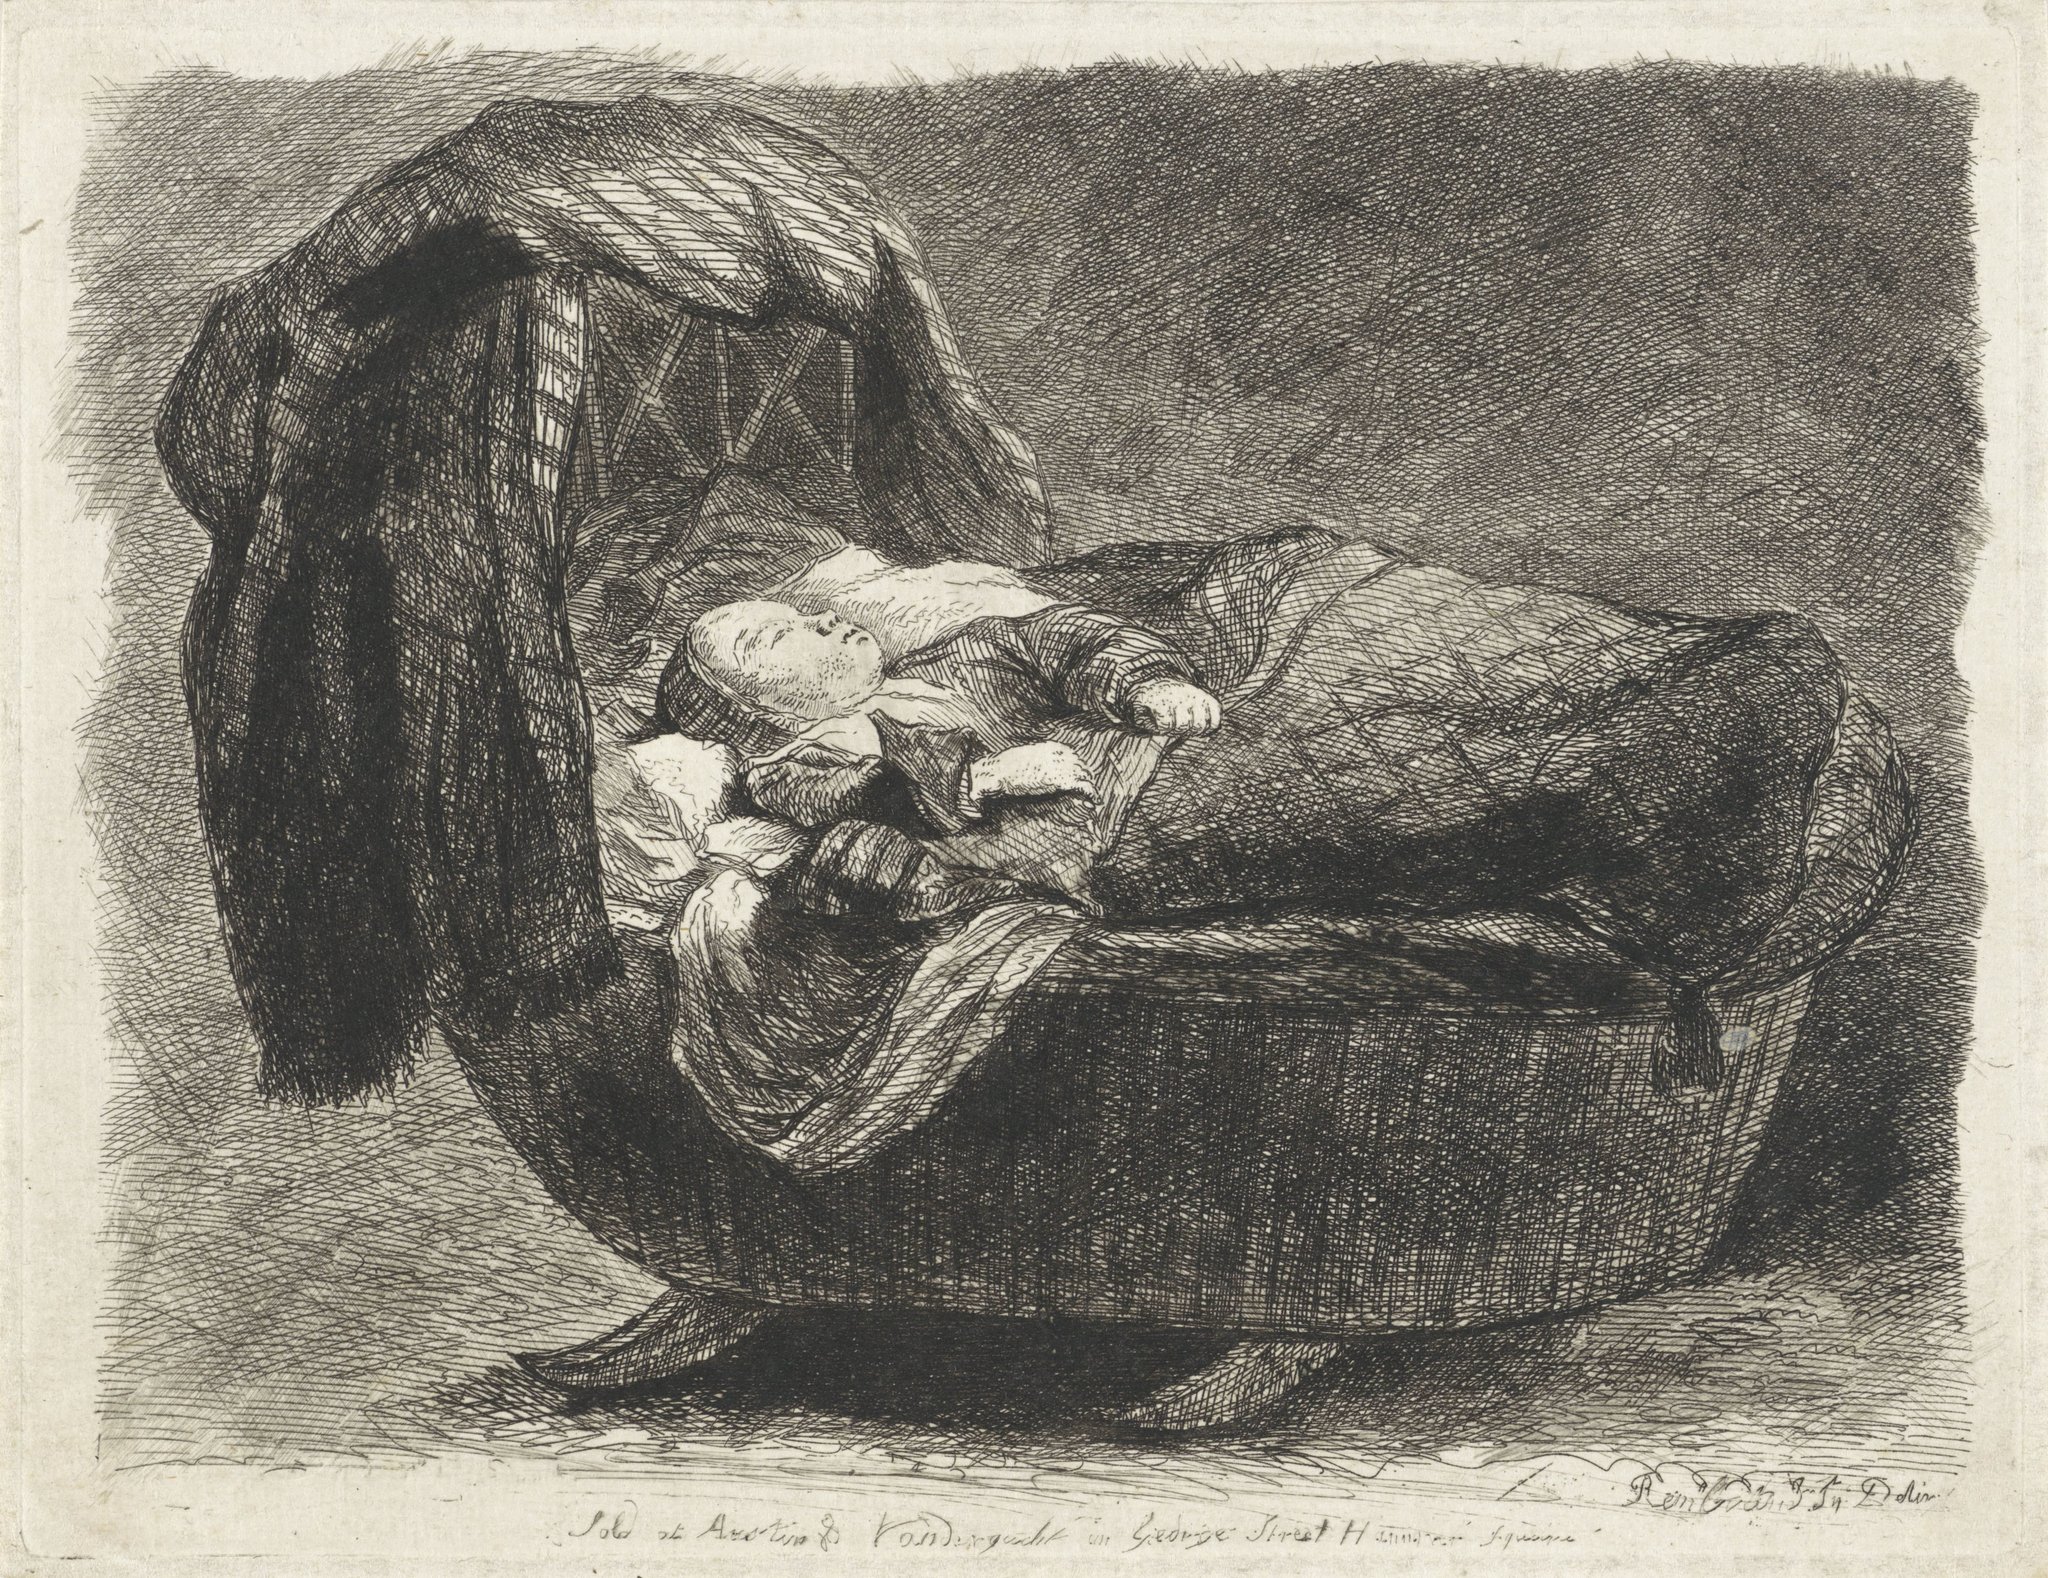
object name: print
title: Slapend kind in een wieg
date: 1625-1816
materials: paper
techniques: etching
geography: low countries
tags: cradle, crib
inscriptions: collector's mark: Lugt 240, collector's mark: Lugt 2228